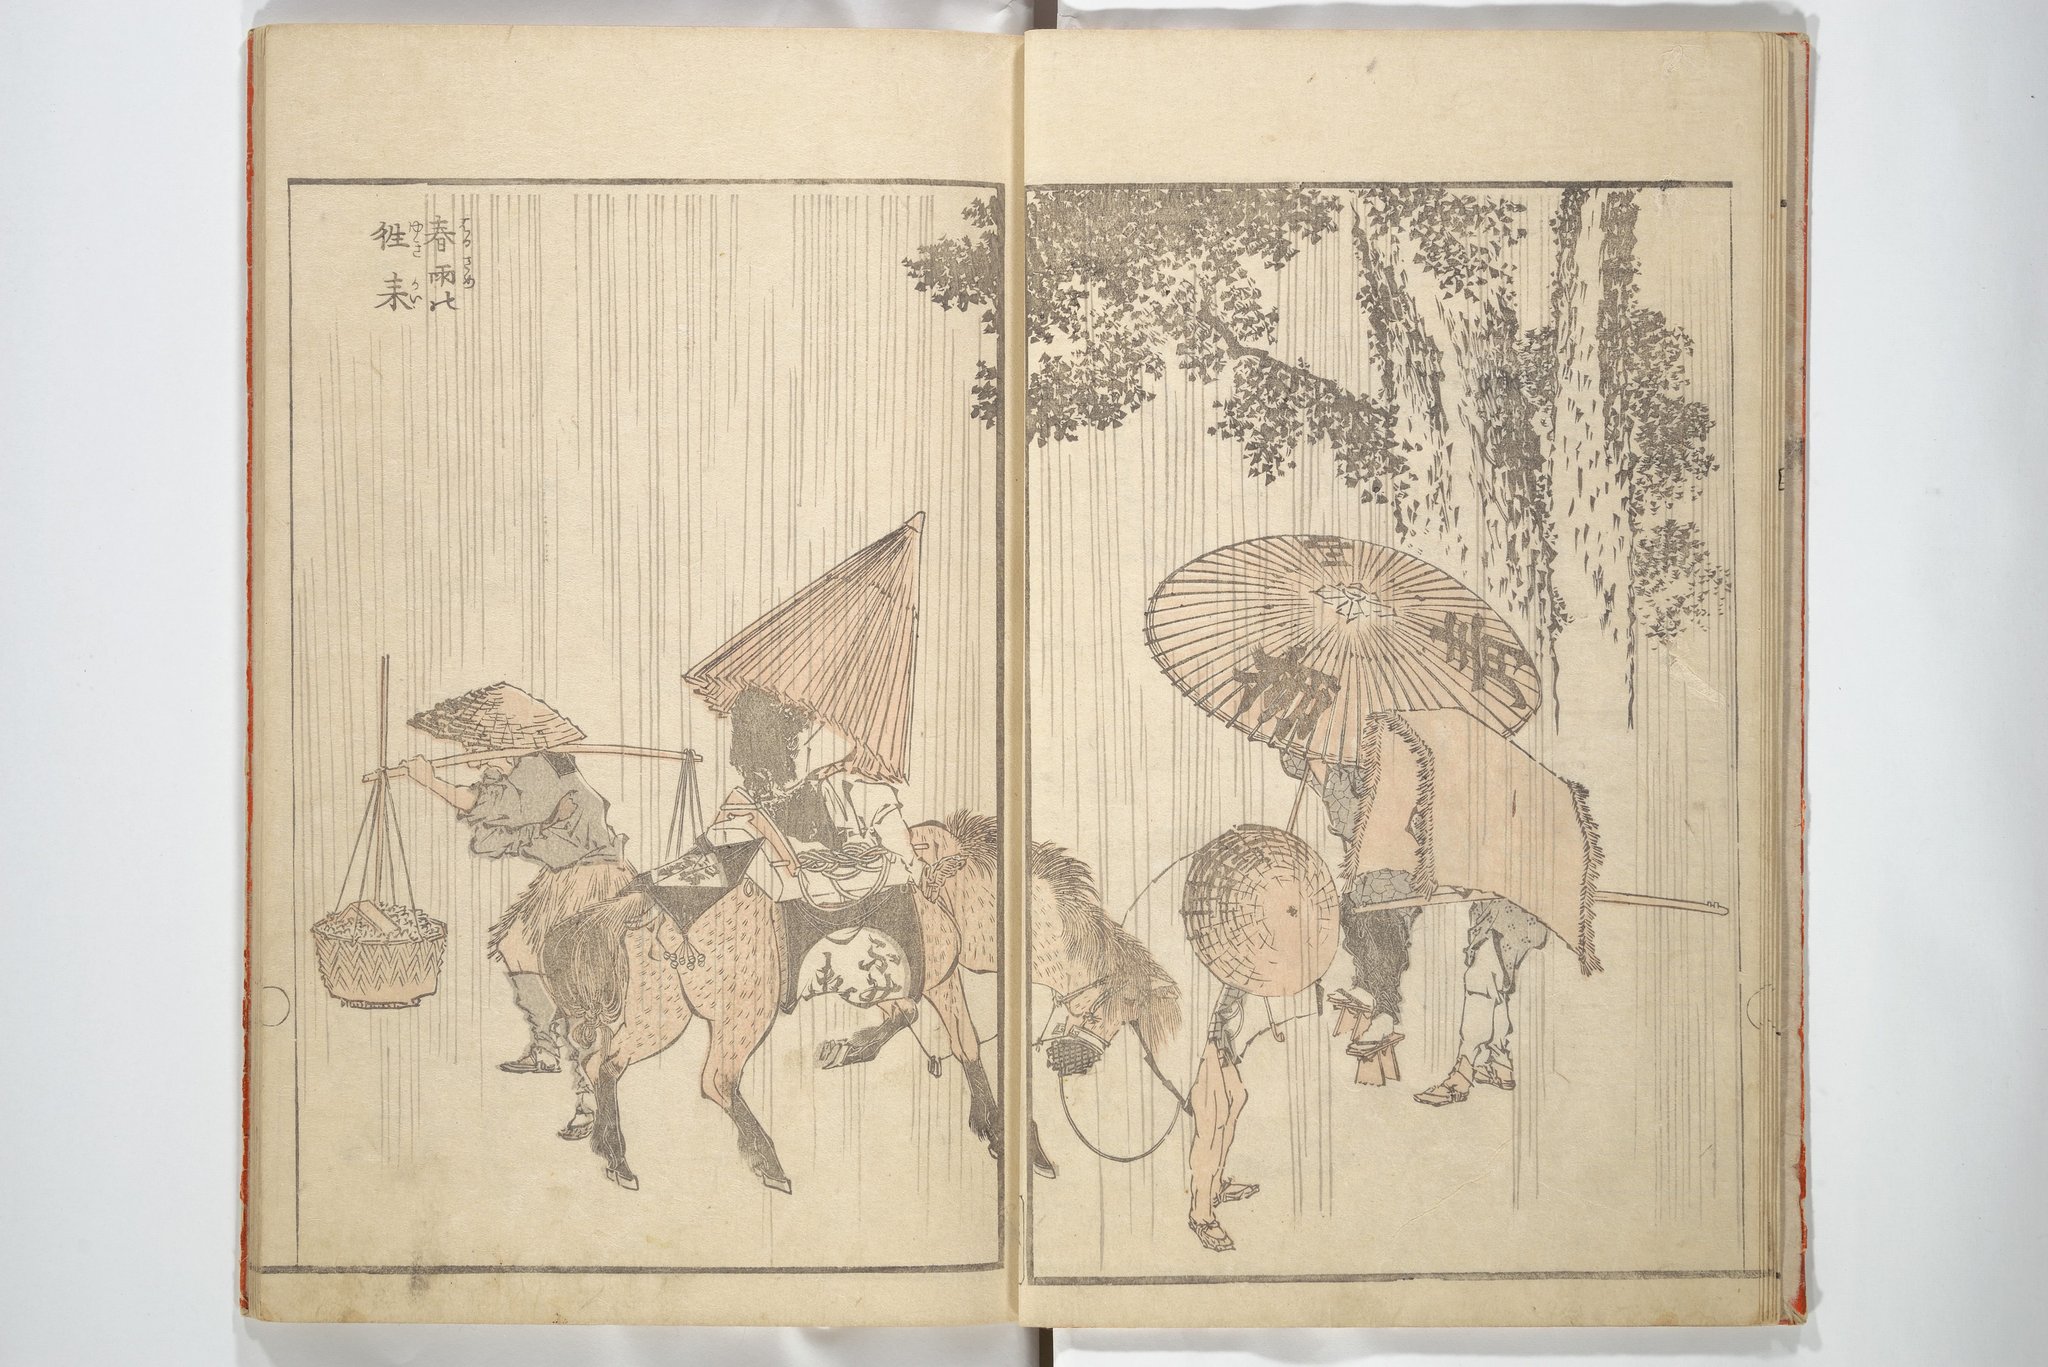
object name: illustrated book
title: Various Pictures by Hokusai (Hokusai soga) 北斎麁画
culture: japanese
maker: katsushika hokusai 葛飾北斎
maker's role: artist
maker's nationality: japanese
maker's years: 1760-1849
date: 1820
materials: ink, paper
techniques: woodblock print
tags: birds,men,women,horses,flowers,working